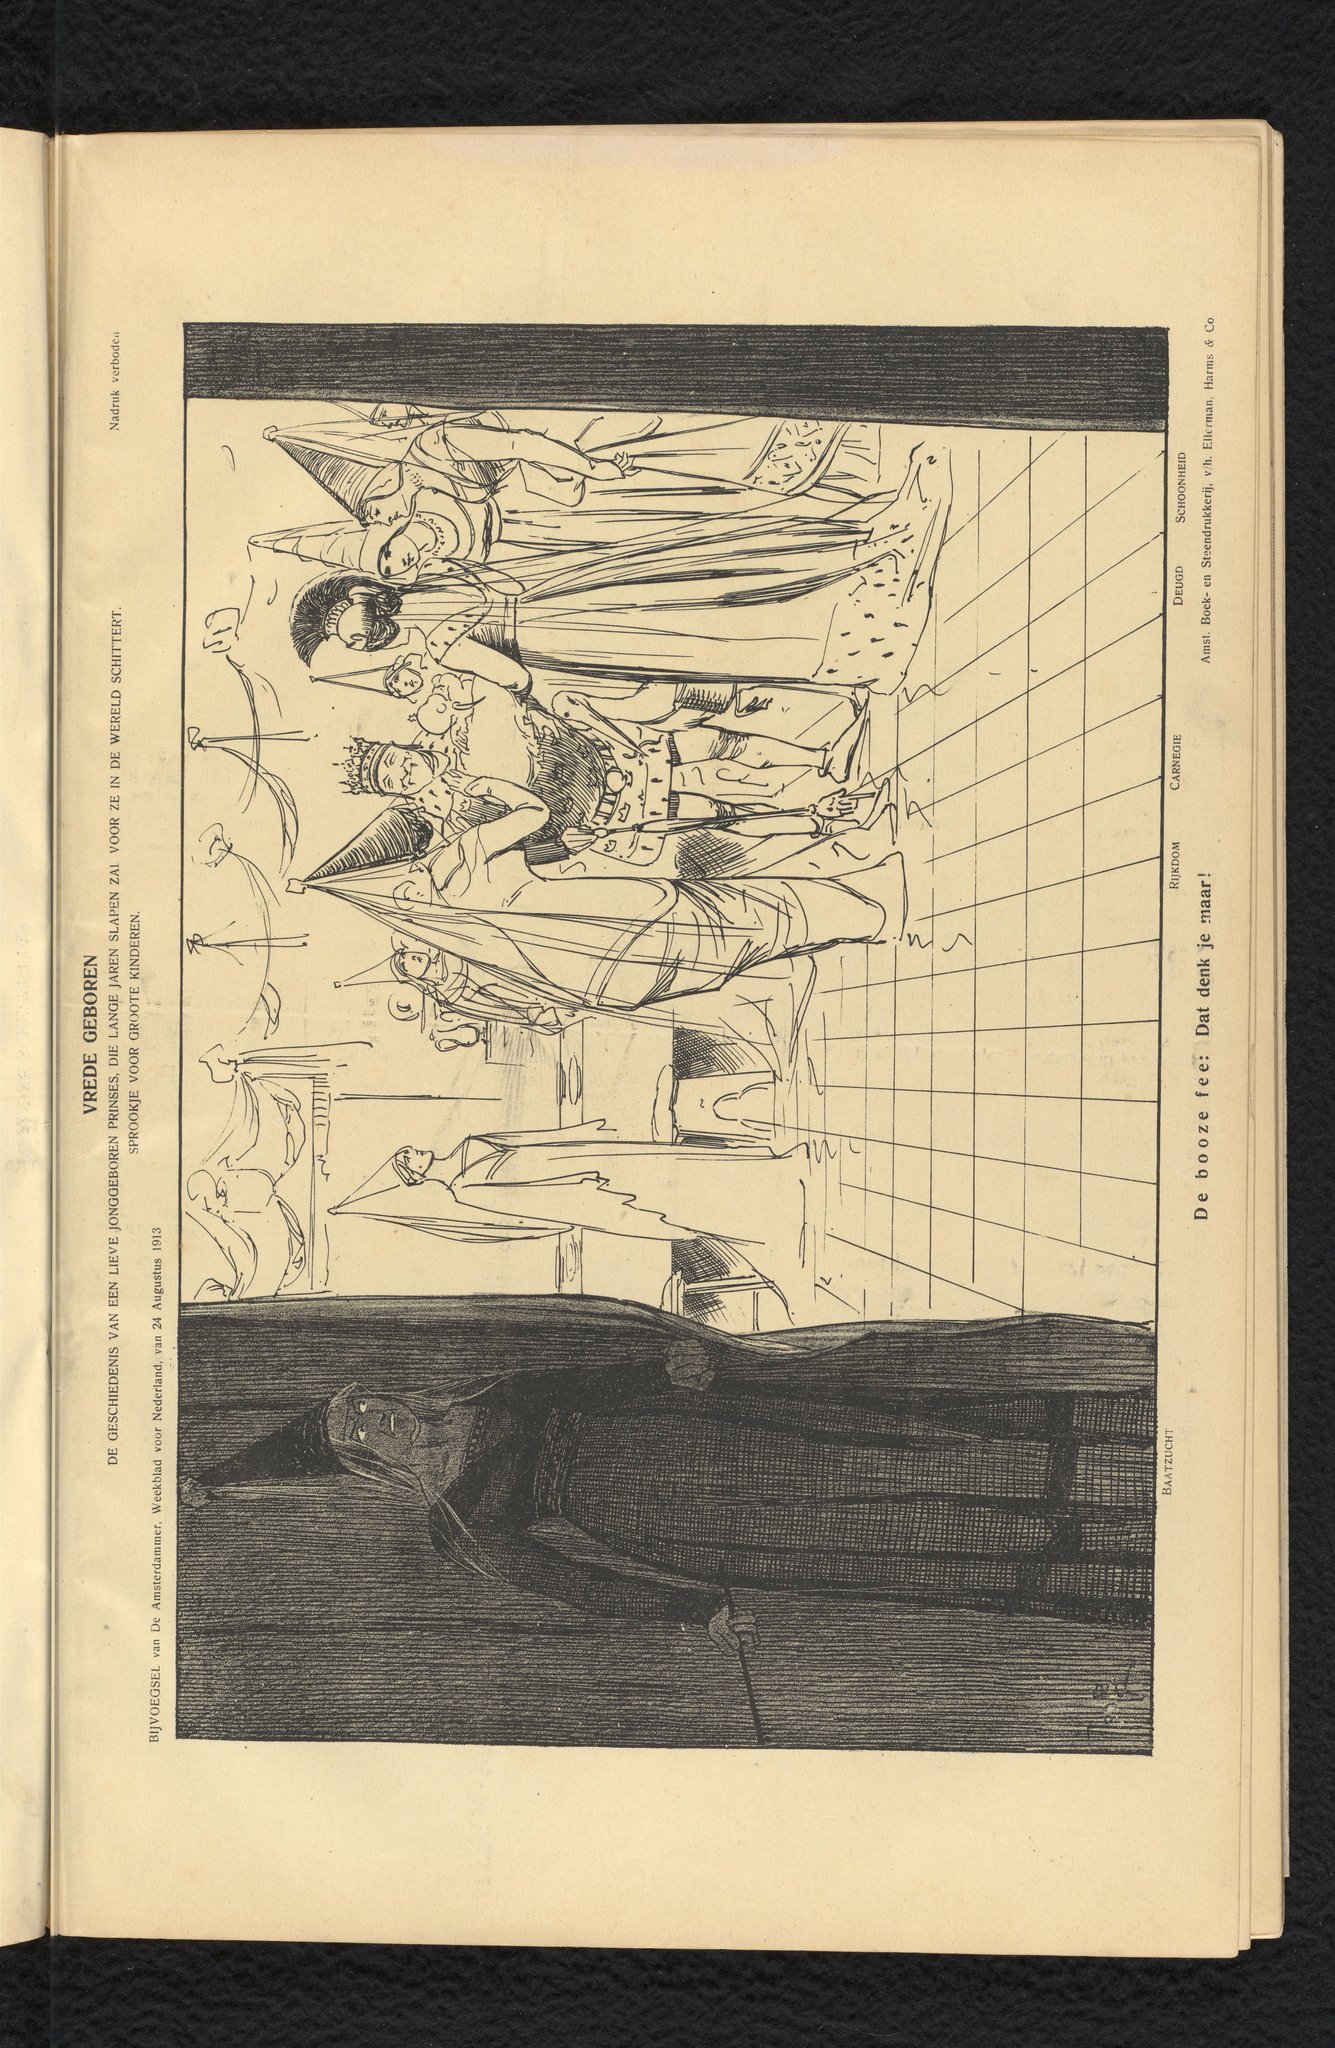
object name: cartoon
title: Vrede geboren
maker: johan braakensiek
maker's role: draughtsman, print maker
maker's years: 1858-1940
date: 1913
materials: paper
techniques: lithograph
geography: amsterdam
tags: personifications of countries, nations, states, districts, etc., benevolence, beneficence; 'beneficio', 'benevolenza o affettione' (ripa), selfishness; 'interesse', 'interesse proprio' (ripa), infant, baby, charitable works, political caricatures and satires, good government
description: Carnegie als de goede koning en vader van de pasgeboren baby van de Vrede, omringd door de jonkvrouwen Rijkdom, Deugd en Schoonheid en de Nederlandse Maagd. Vanachter een gordijn kijkt de boze fee Baatzucht (Eigenbelang) verbitterd toe.